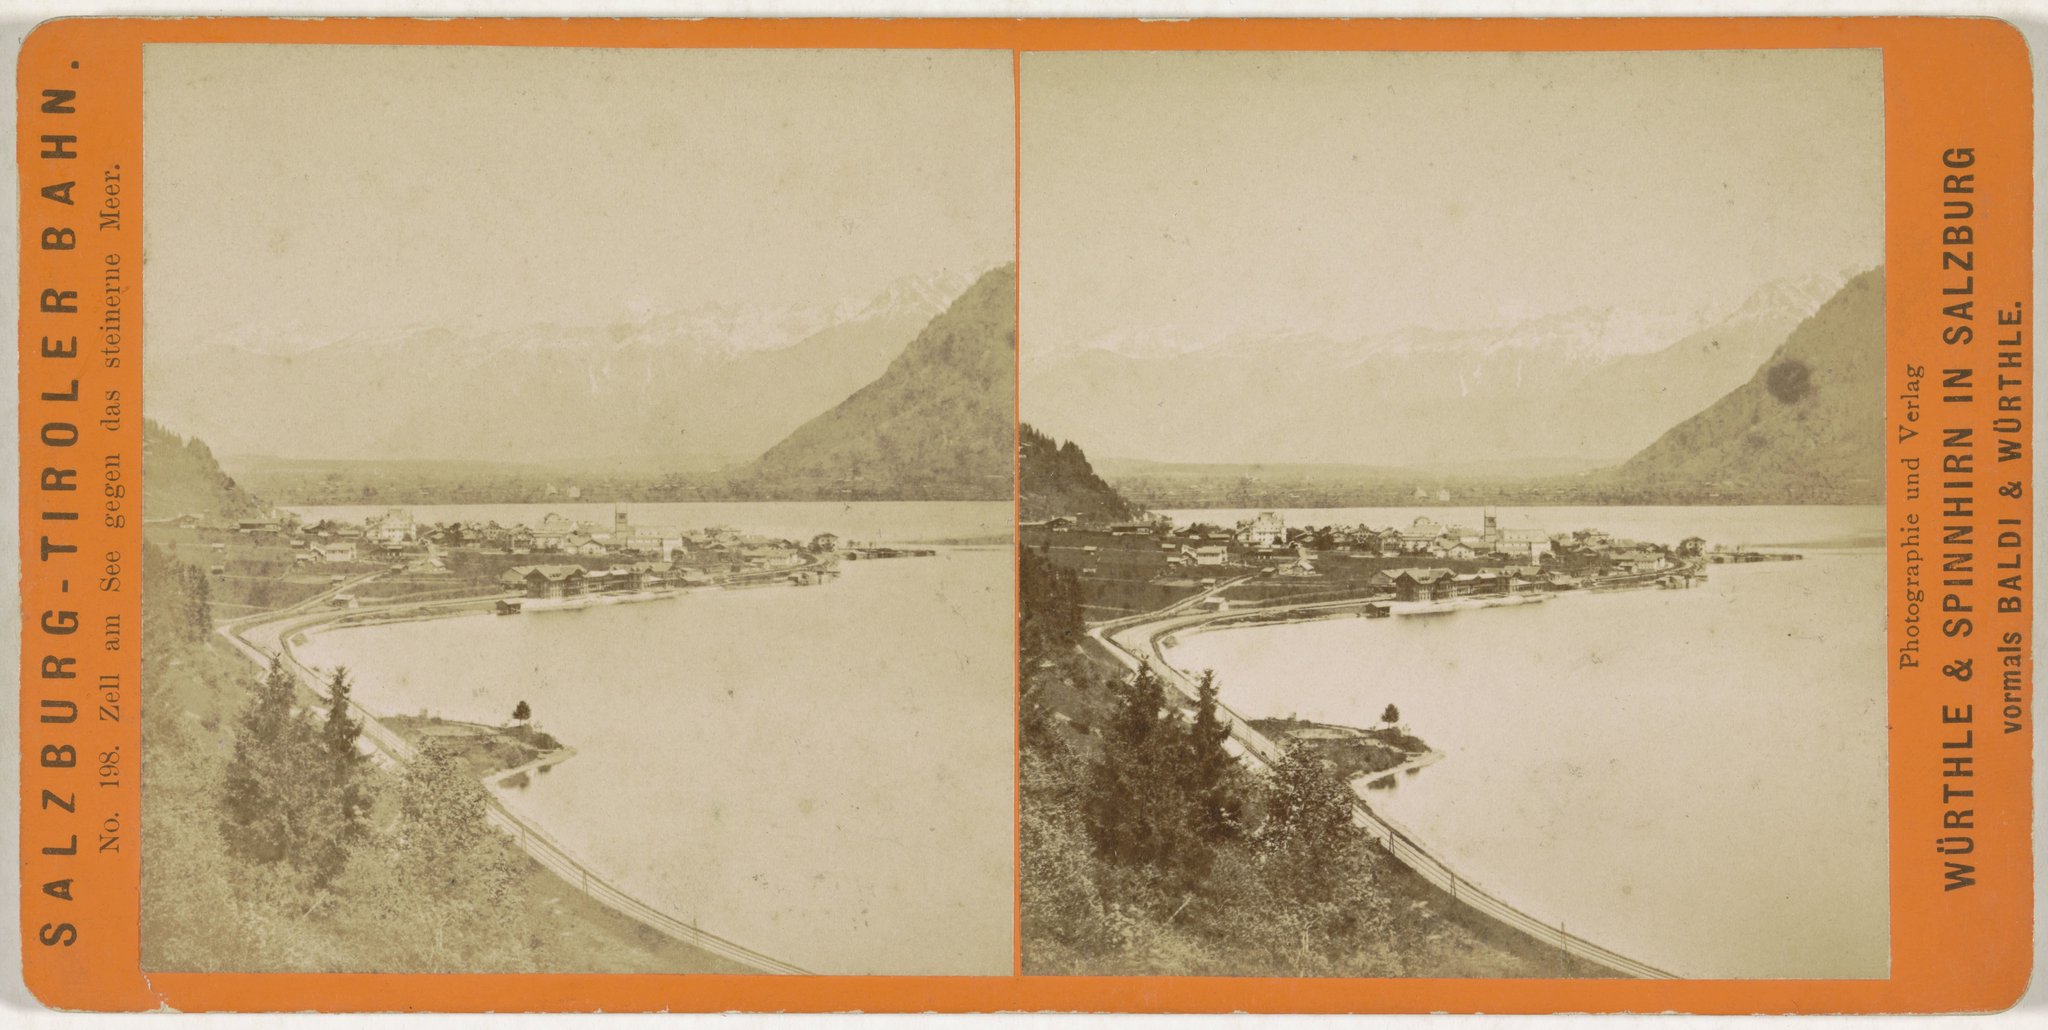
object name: stereograph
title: Zell am See gegen das steinerne Meer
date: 1881-1892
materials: cardboard, paper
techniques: albumen print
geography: zell am see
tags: prospect of village, silhouette of village, mountains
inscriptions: number: ‘No. 198’, inscription: ‘vormals Baldi & Würthle’